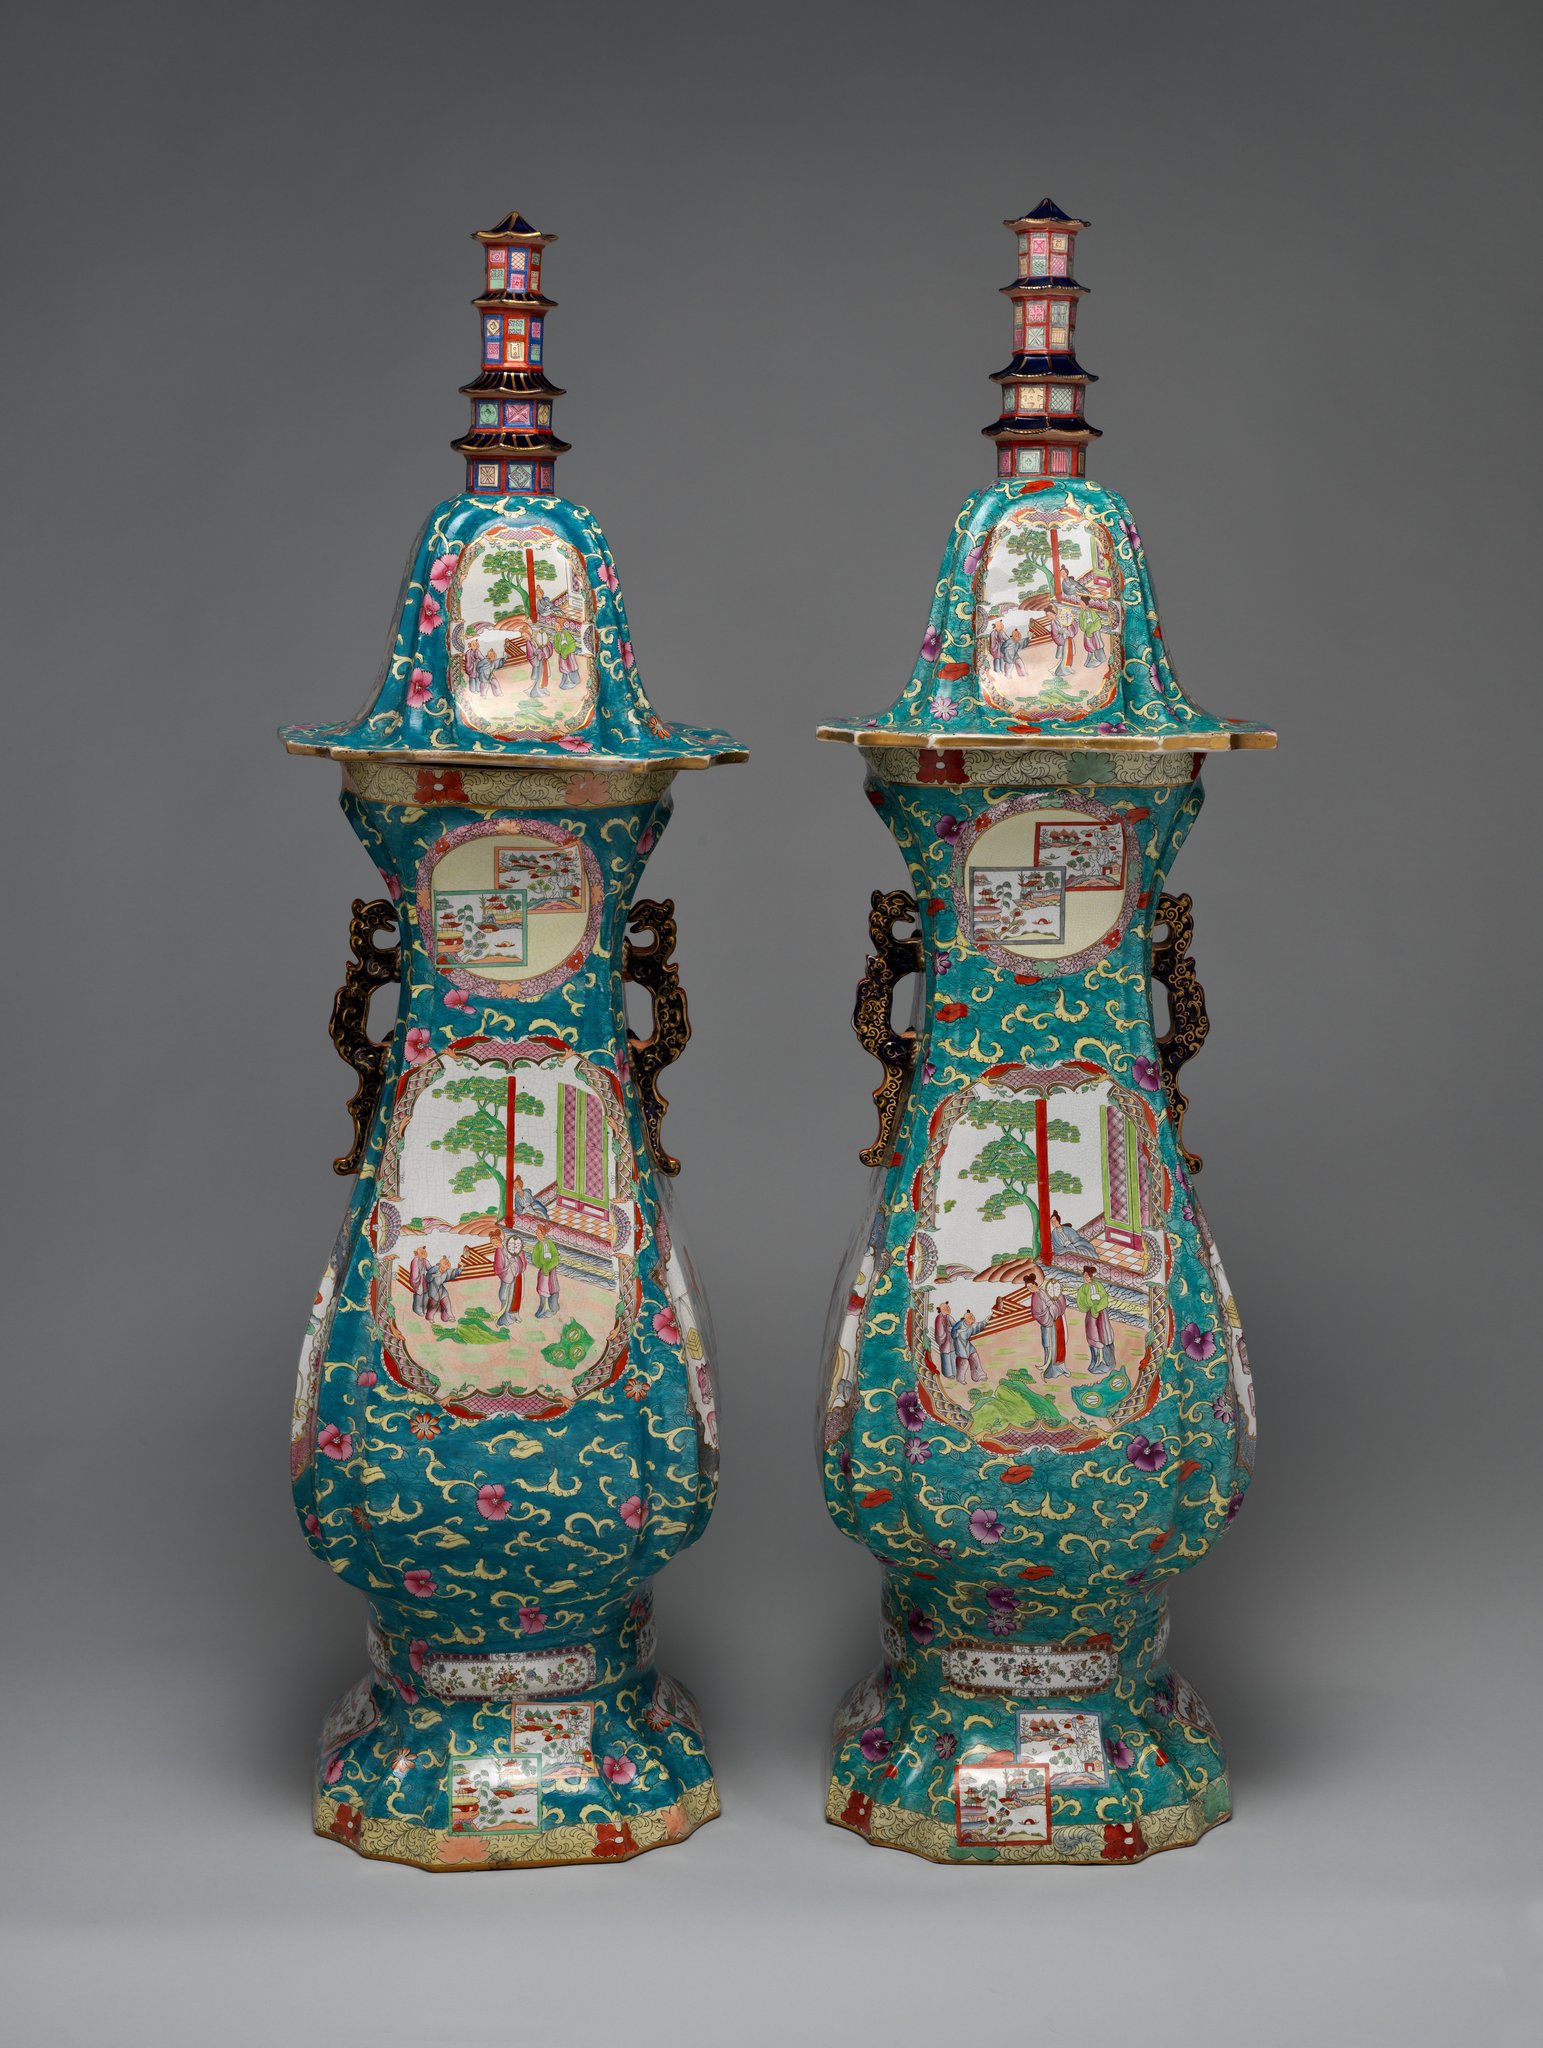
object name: vase with cover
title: Vase with lid (one of a pair)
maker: c. j. mason and co.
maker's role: manufactory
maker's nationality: british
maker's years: 1826-1848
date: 1826-1845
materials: earthenware, enamel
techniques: transfer